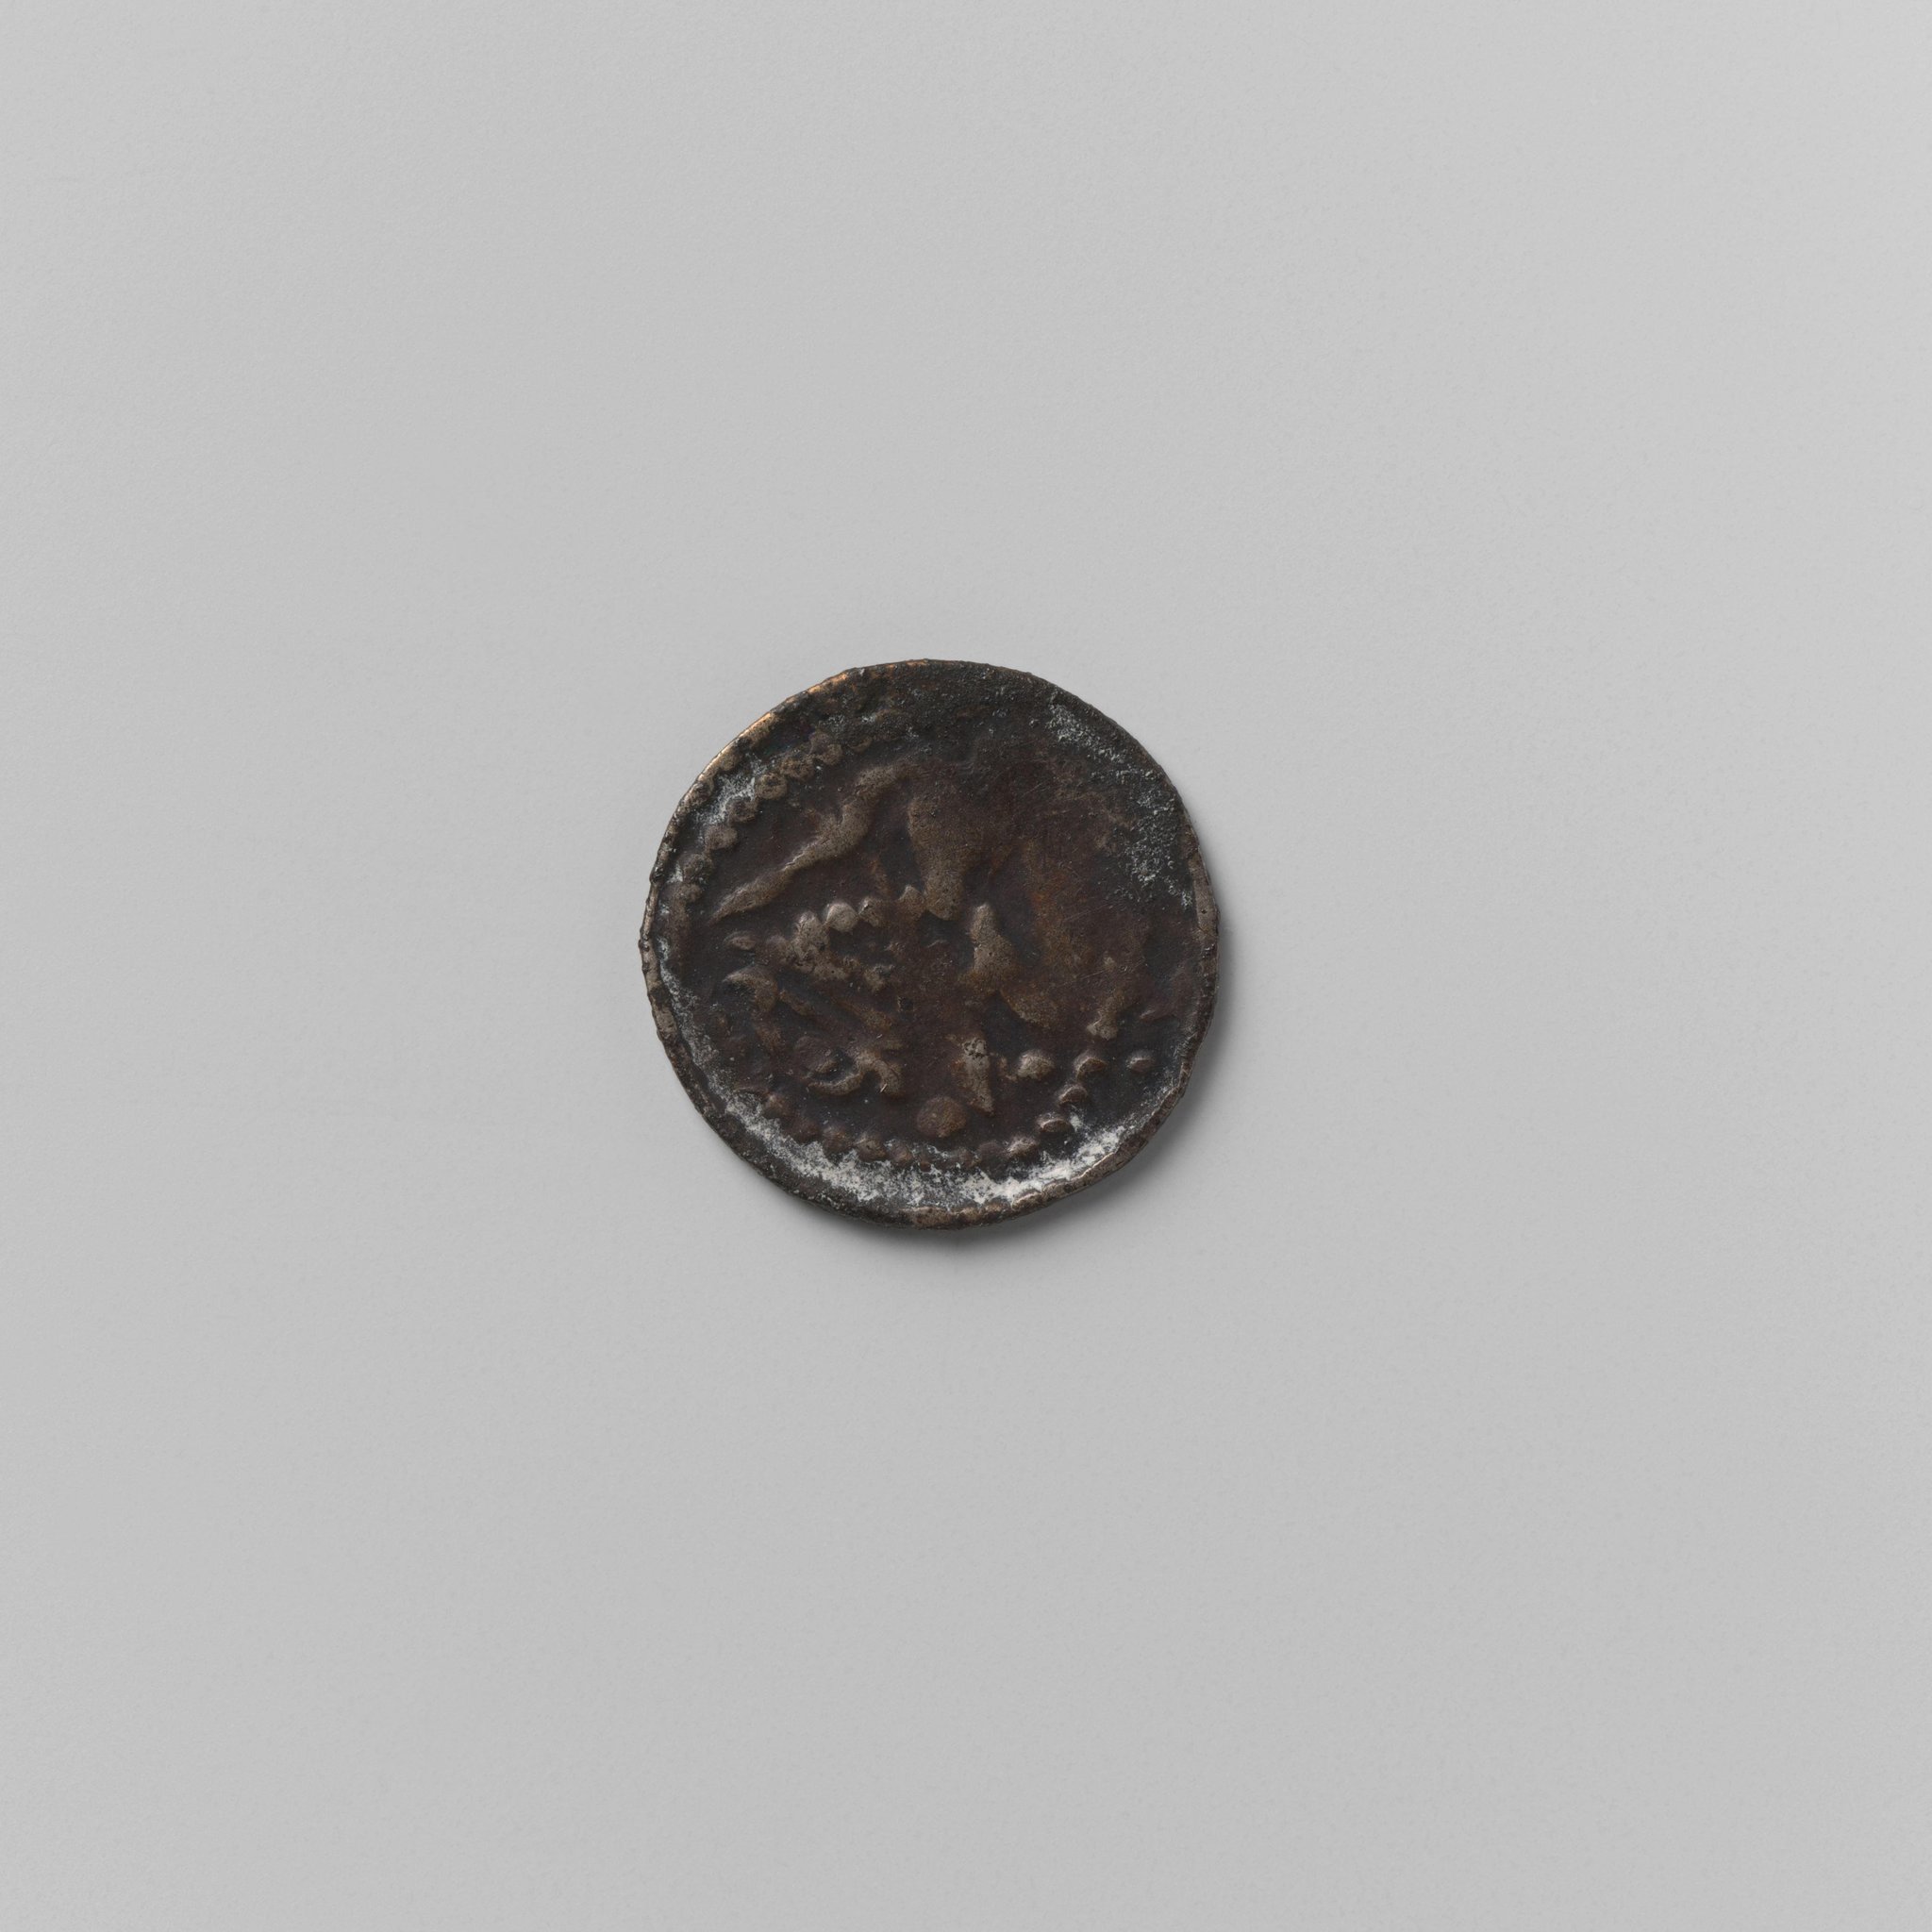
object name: coin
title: Penning uit Brabant van Hendrik II/III, 1235-1261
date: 1235-1261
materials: silver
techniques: striking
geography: tienen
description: Voorzijde: in een punt uitlopend wapenschild met leeuw. Keerzijde: versierd kruis, in de hoeken letters.